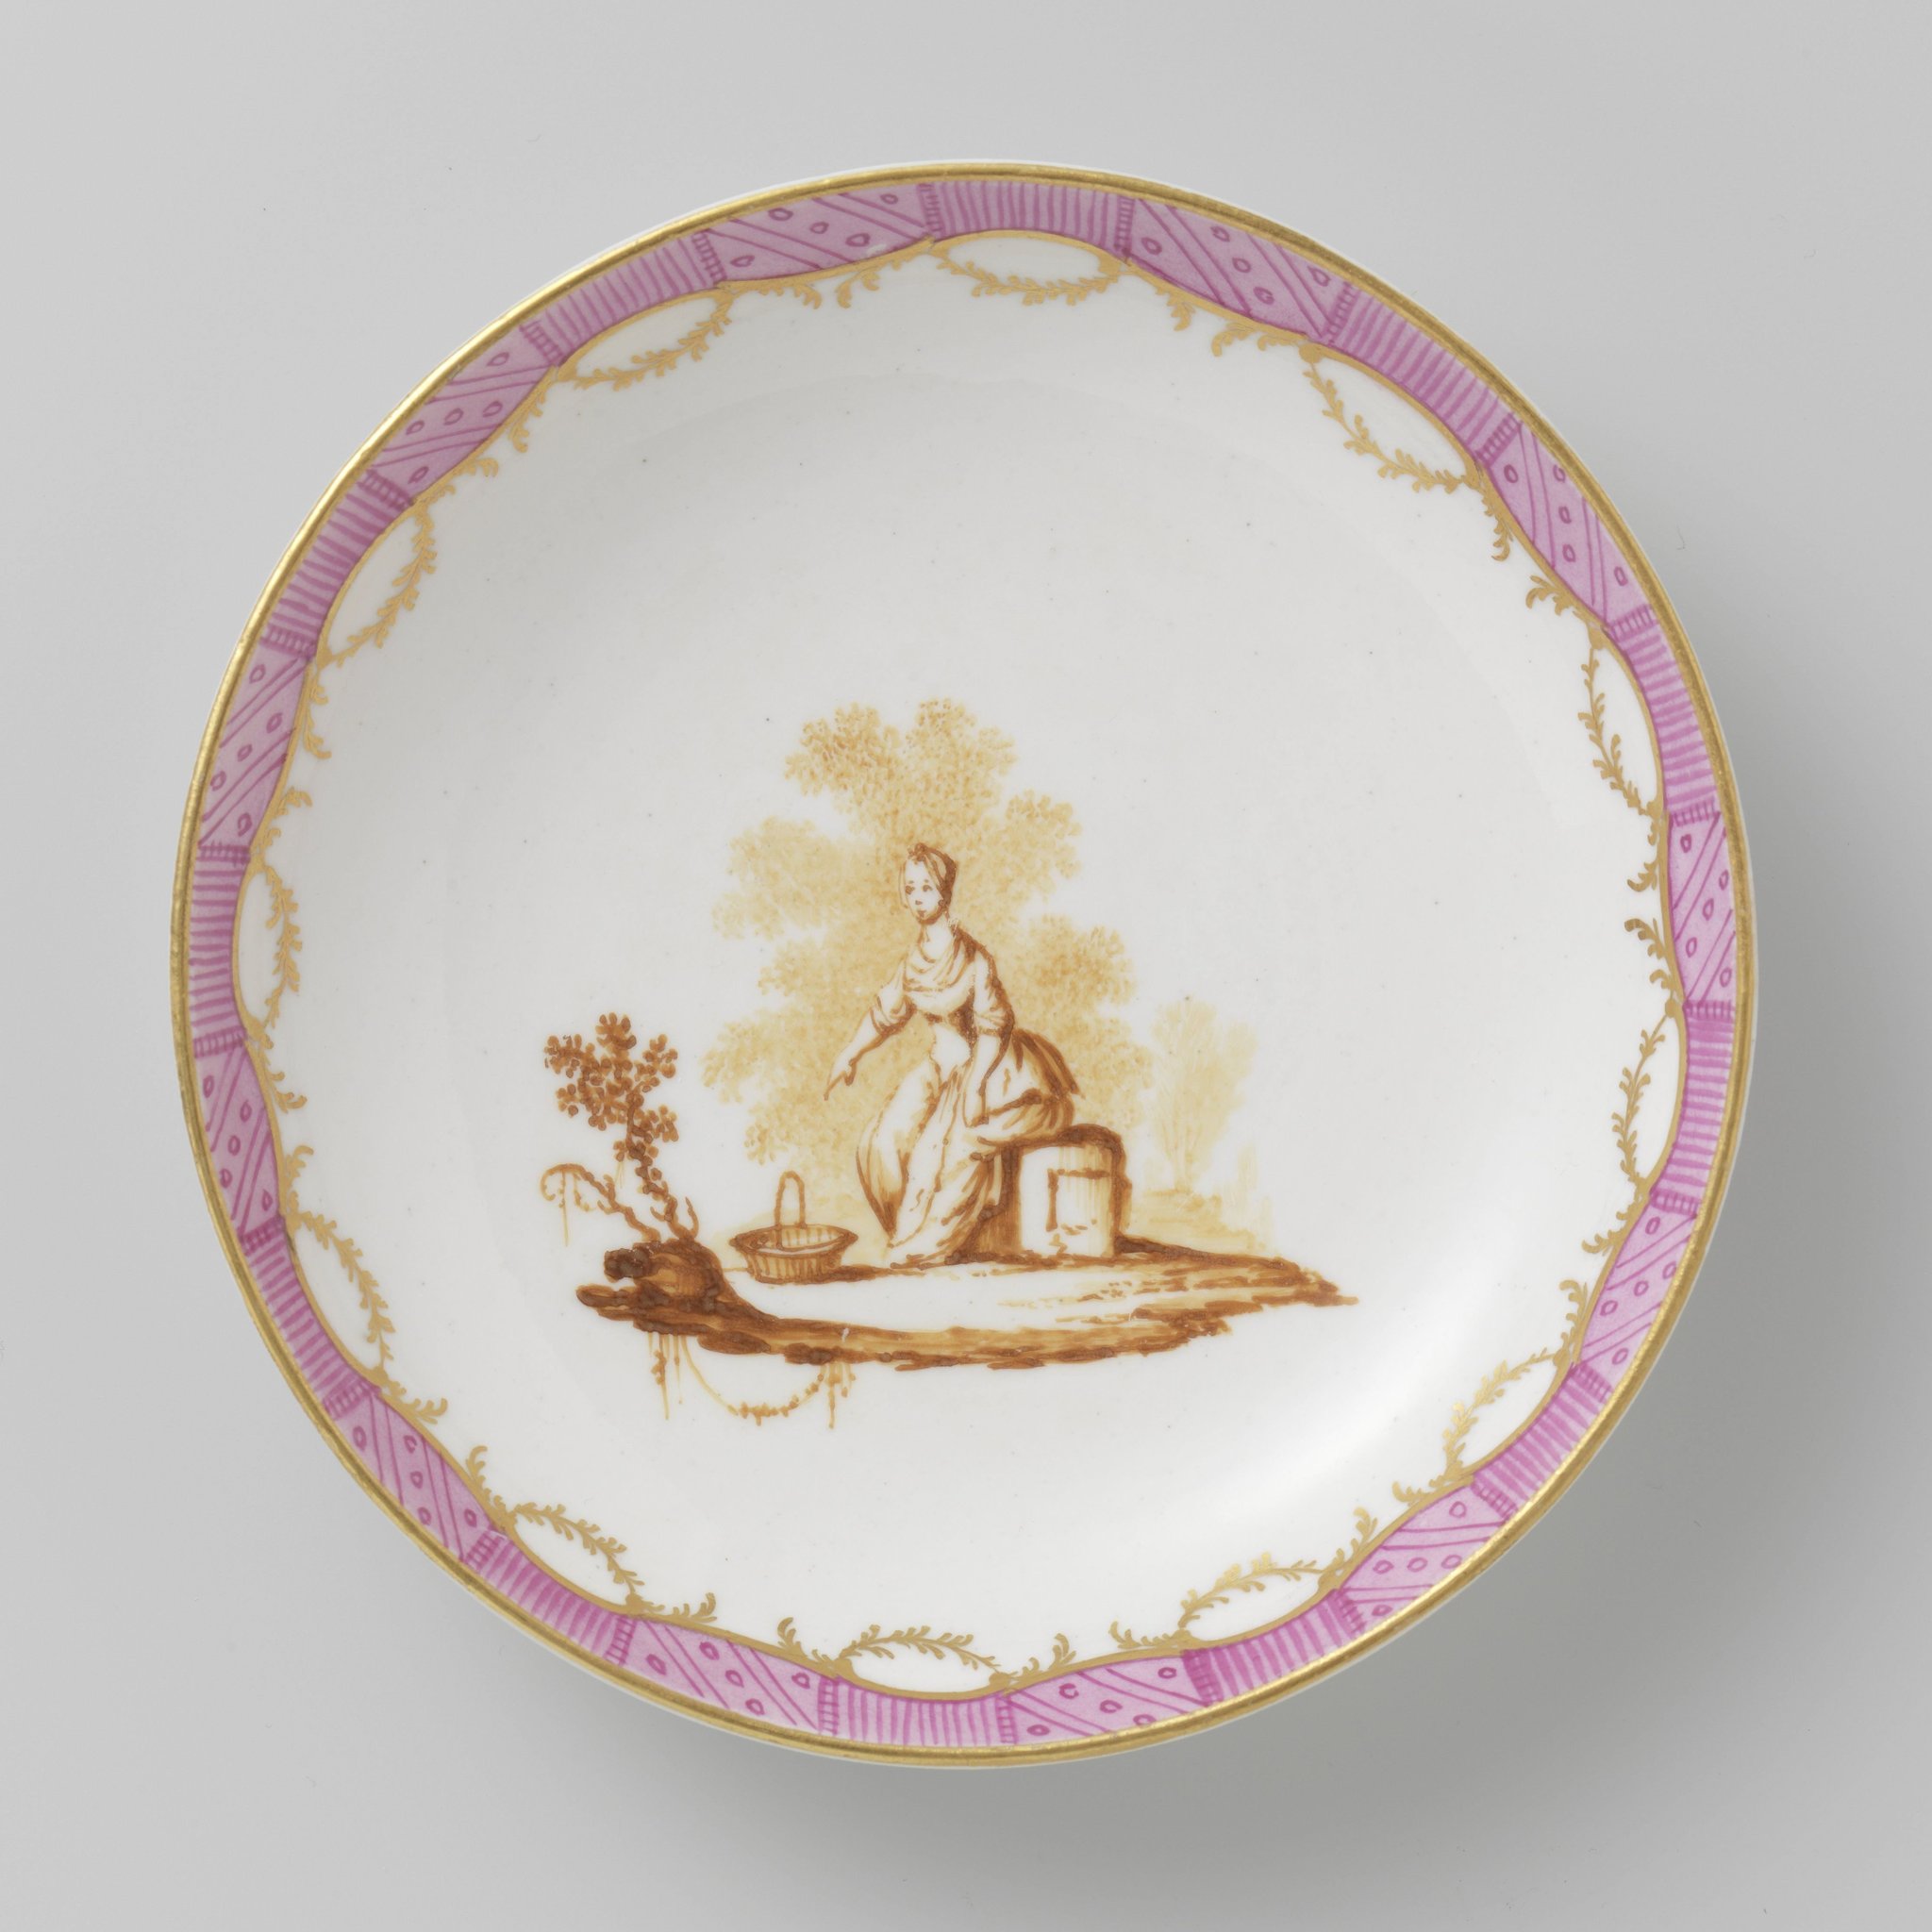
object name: platter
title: Tea service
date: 1774-1778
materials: porcelain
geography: loosdrecht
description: Tea services represented a significant part of the production of the Loosdrecht porcelain factory. On display here are a teapot, milk jug and sugar bowl along with other less familiar parts of a tea service, such as a slop bowl, which is used to rinse and warm the cups between two ‘courses’, and a drip catcher (pattipan), which catches the drips from the spout of the teapot.